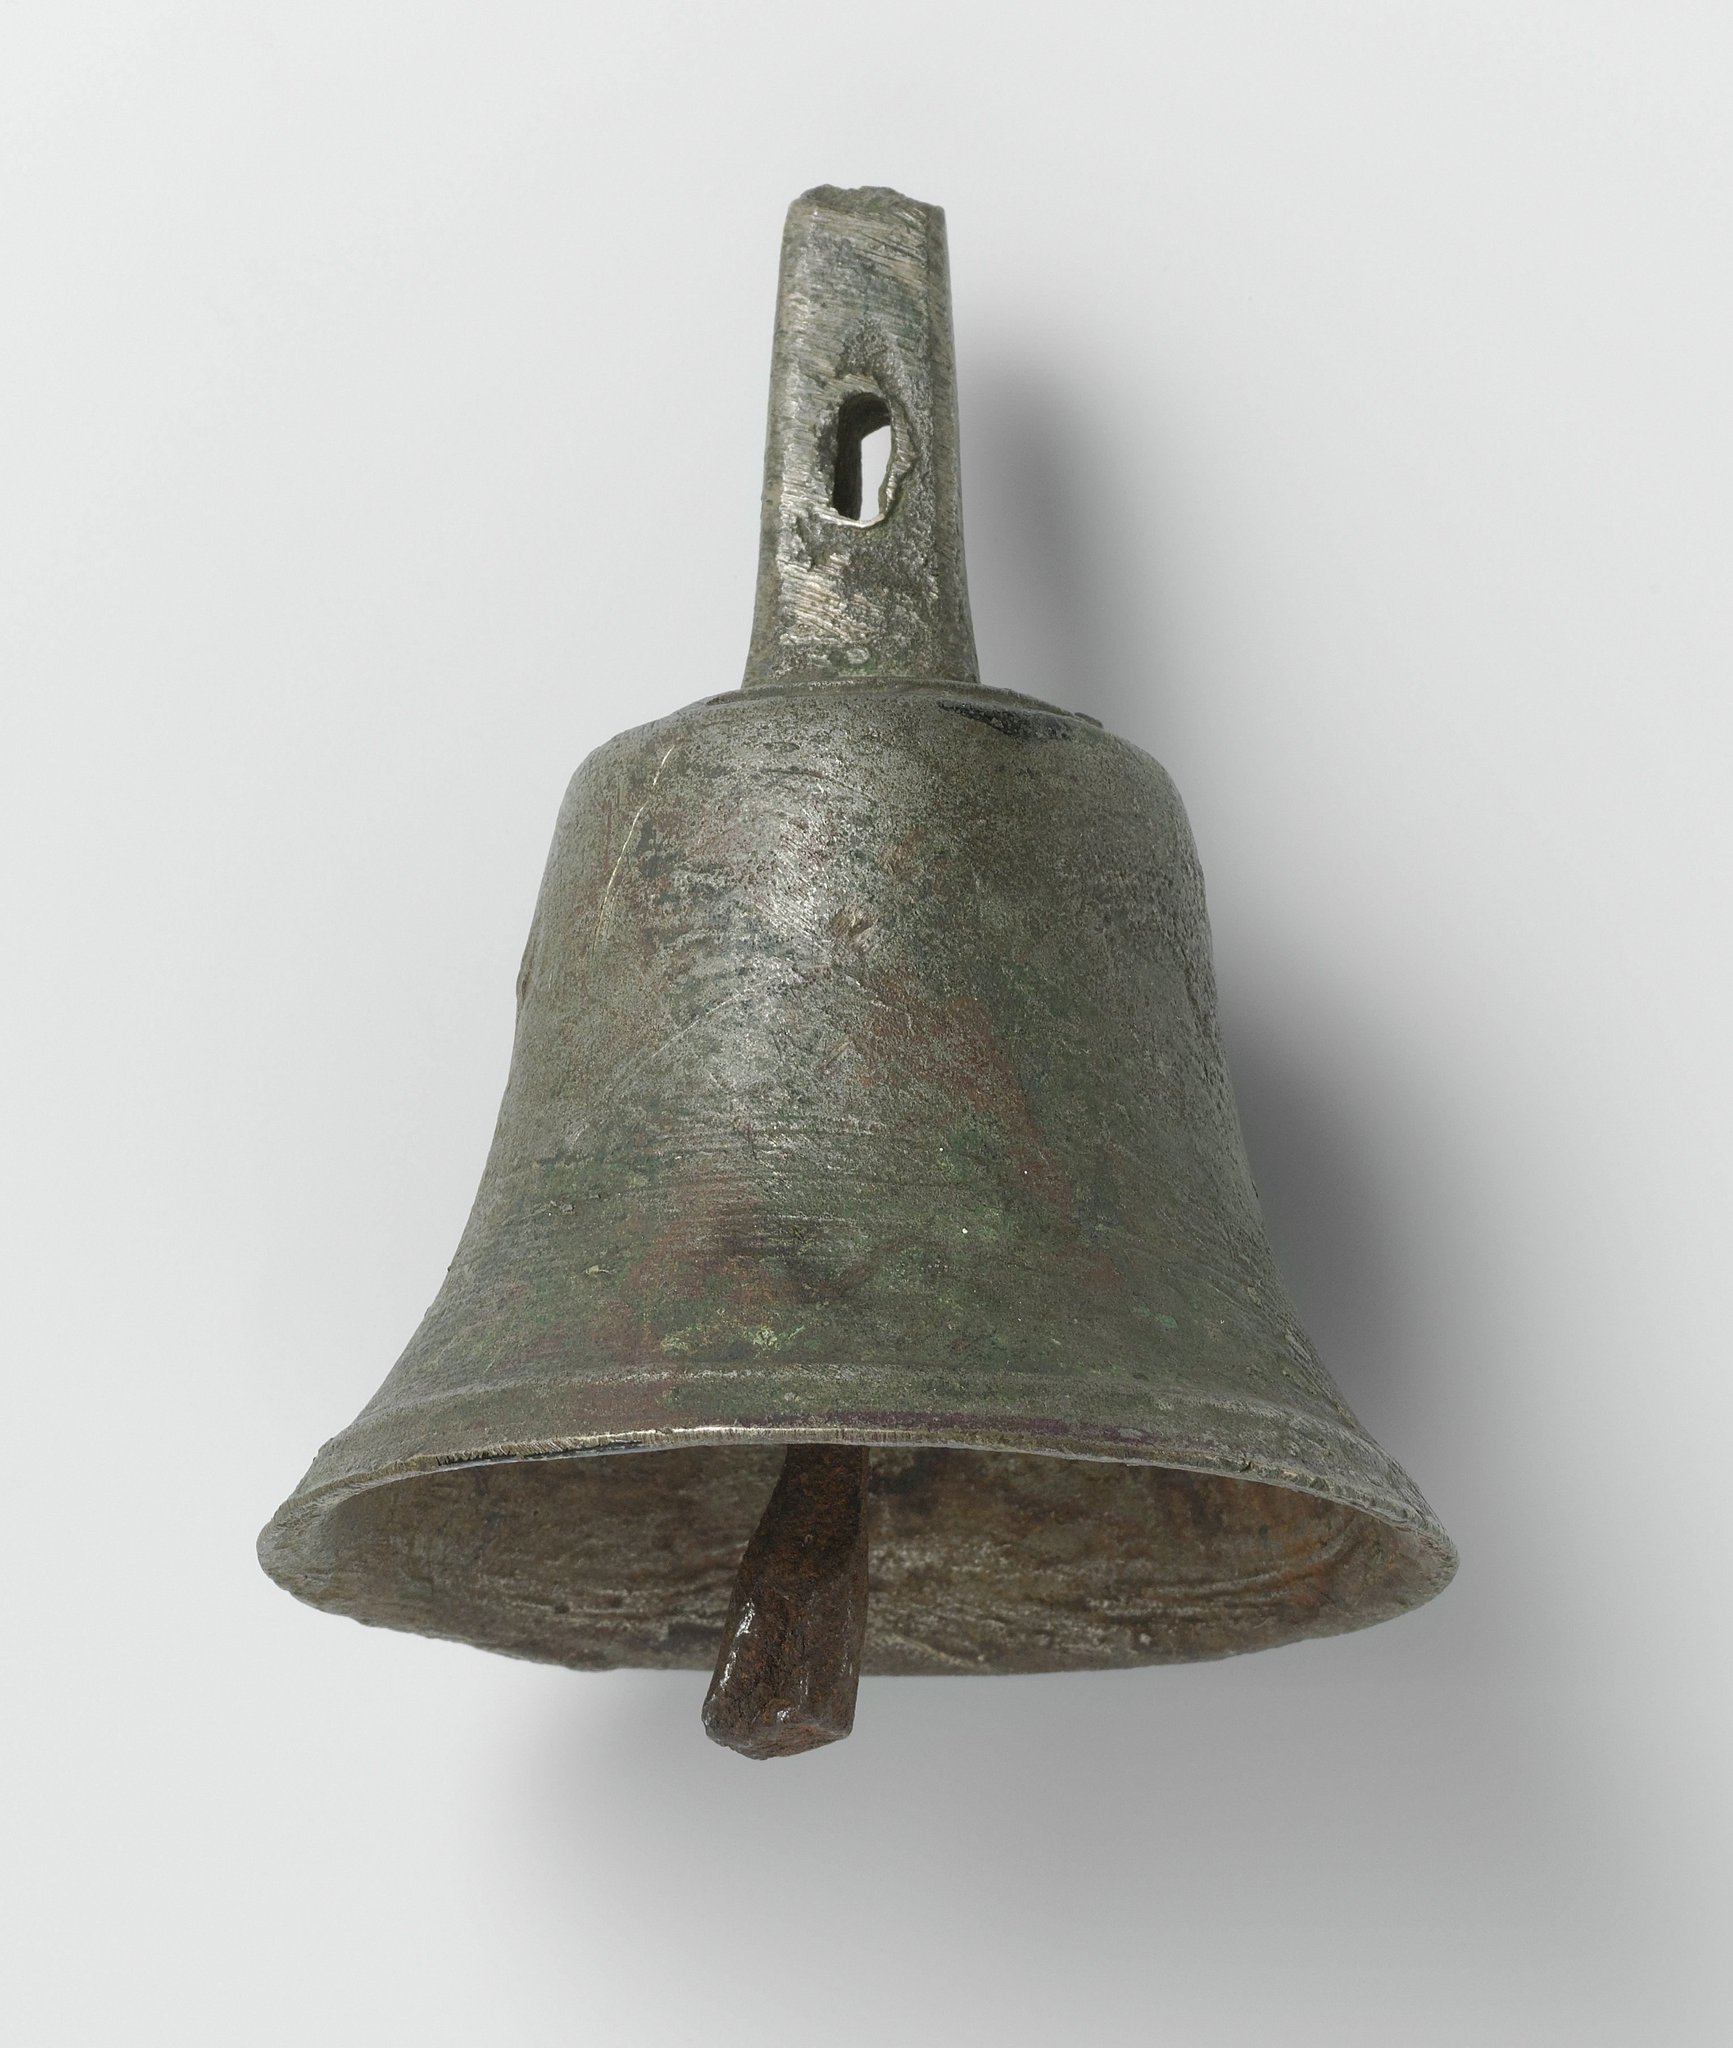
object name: musical instrument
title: Bell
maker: Anonymous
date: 1590-1596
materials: bronze, iron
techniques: casting, forging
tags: willem barendsz., amsterdam, jacob van heemskerck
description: Bel van brons met ijzeren klepel en aan de bovenzijden een meegegoten ophanghaakje. De bel hoort vermoedelijk bij een uurwerk.